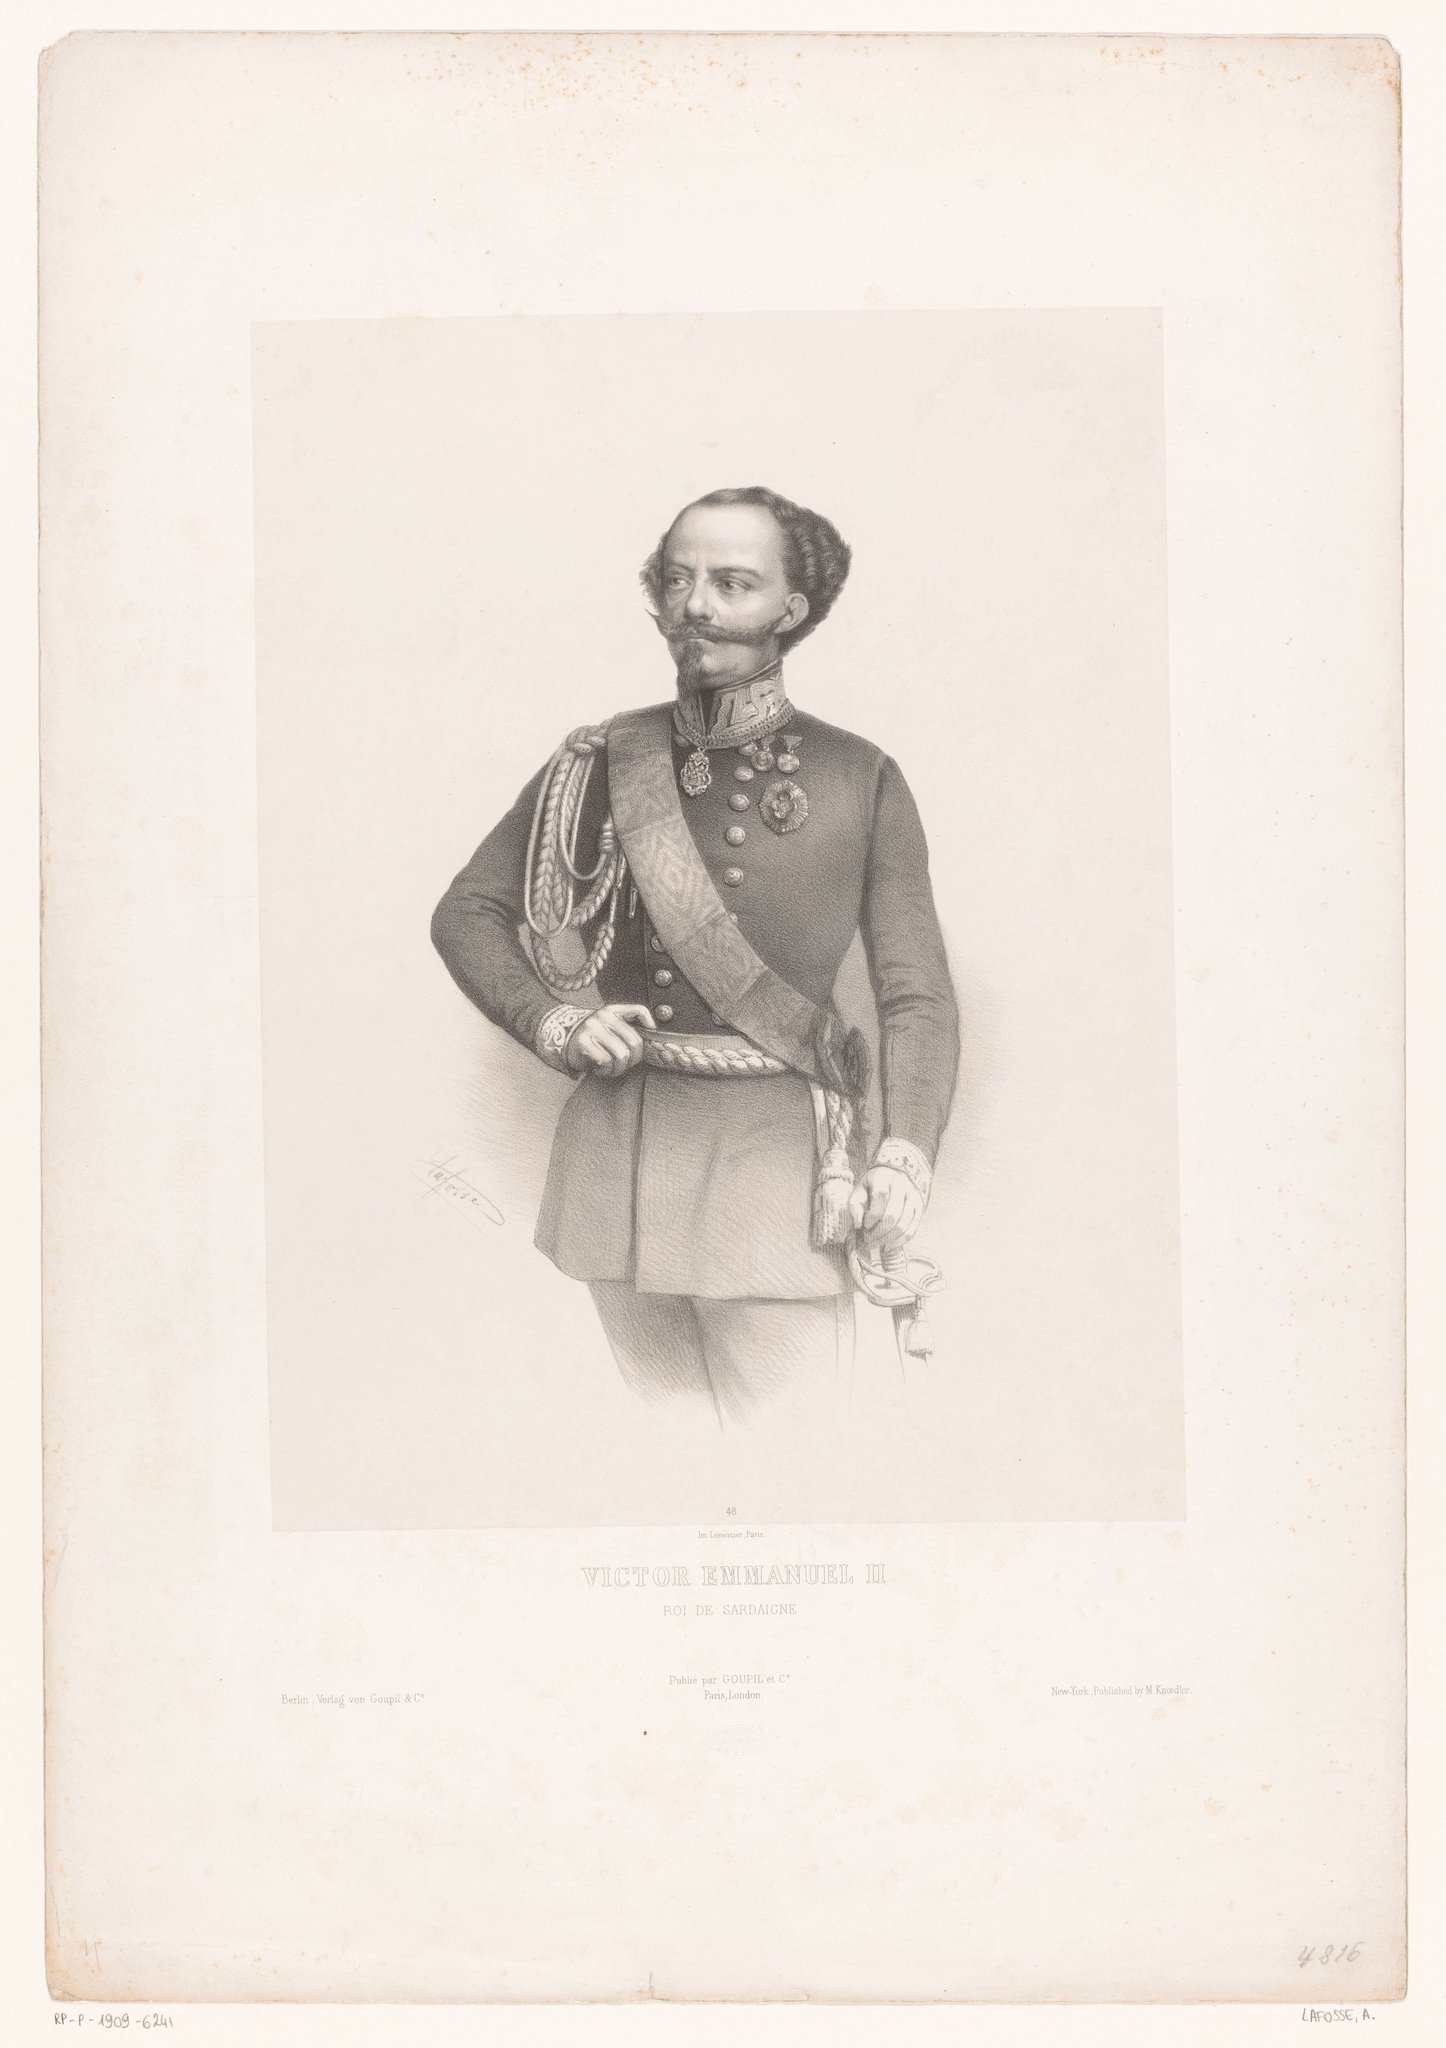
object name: print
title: Victor Emmanuel II, Roi de Sardaigne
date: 1859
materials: paper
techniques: lithograph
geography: new york city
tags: rome, historical persons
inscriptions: check stamp: Lugt 1090, collector's mark: Lugt 2228a